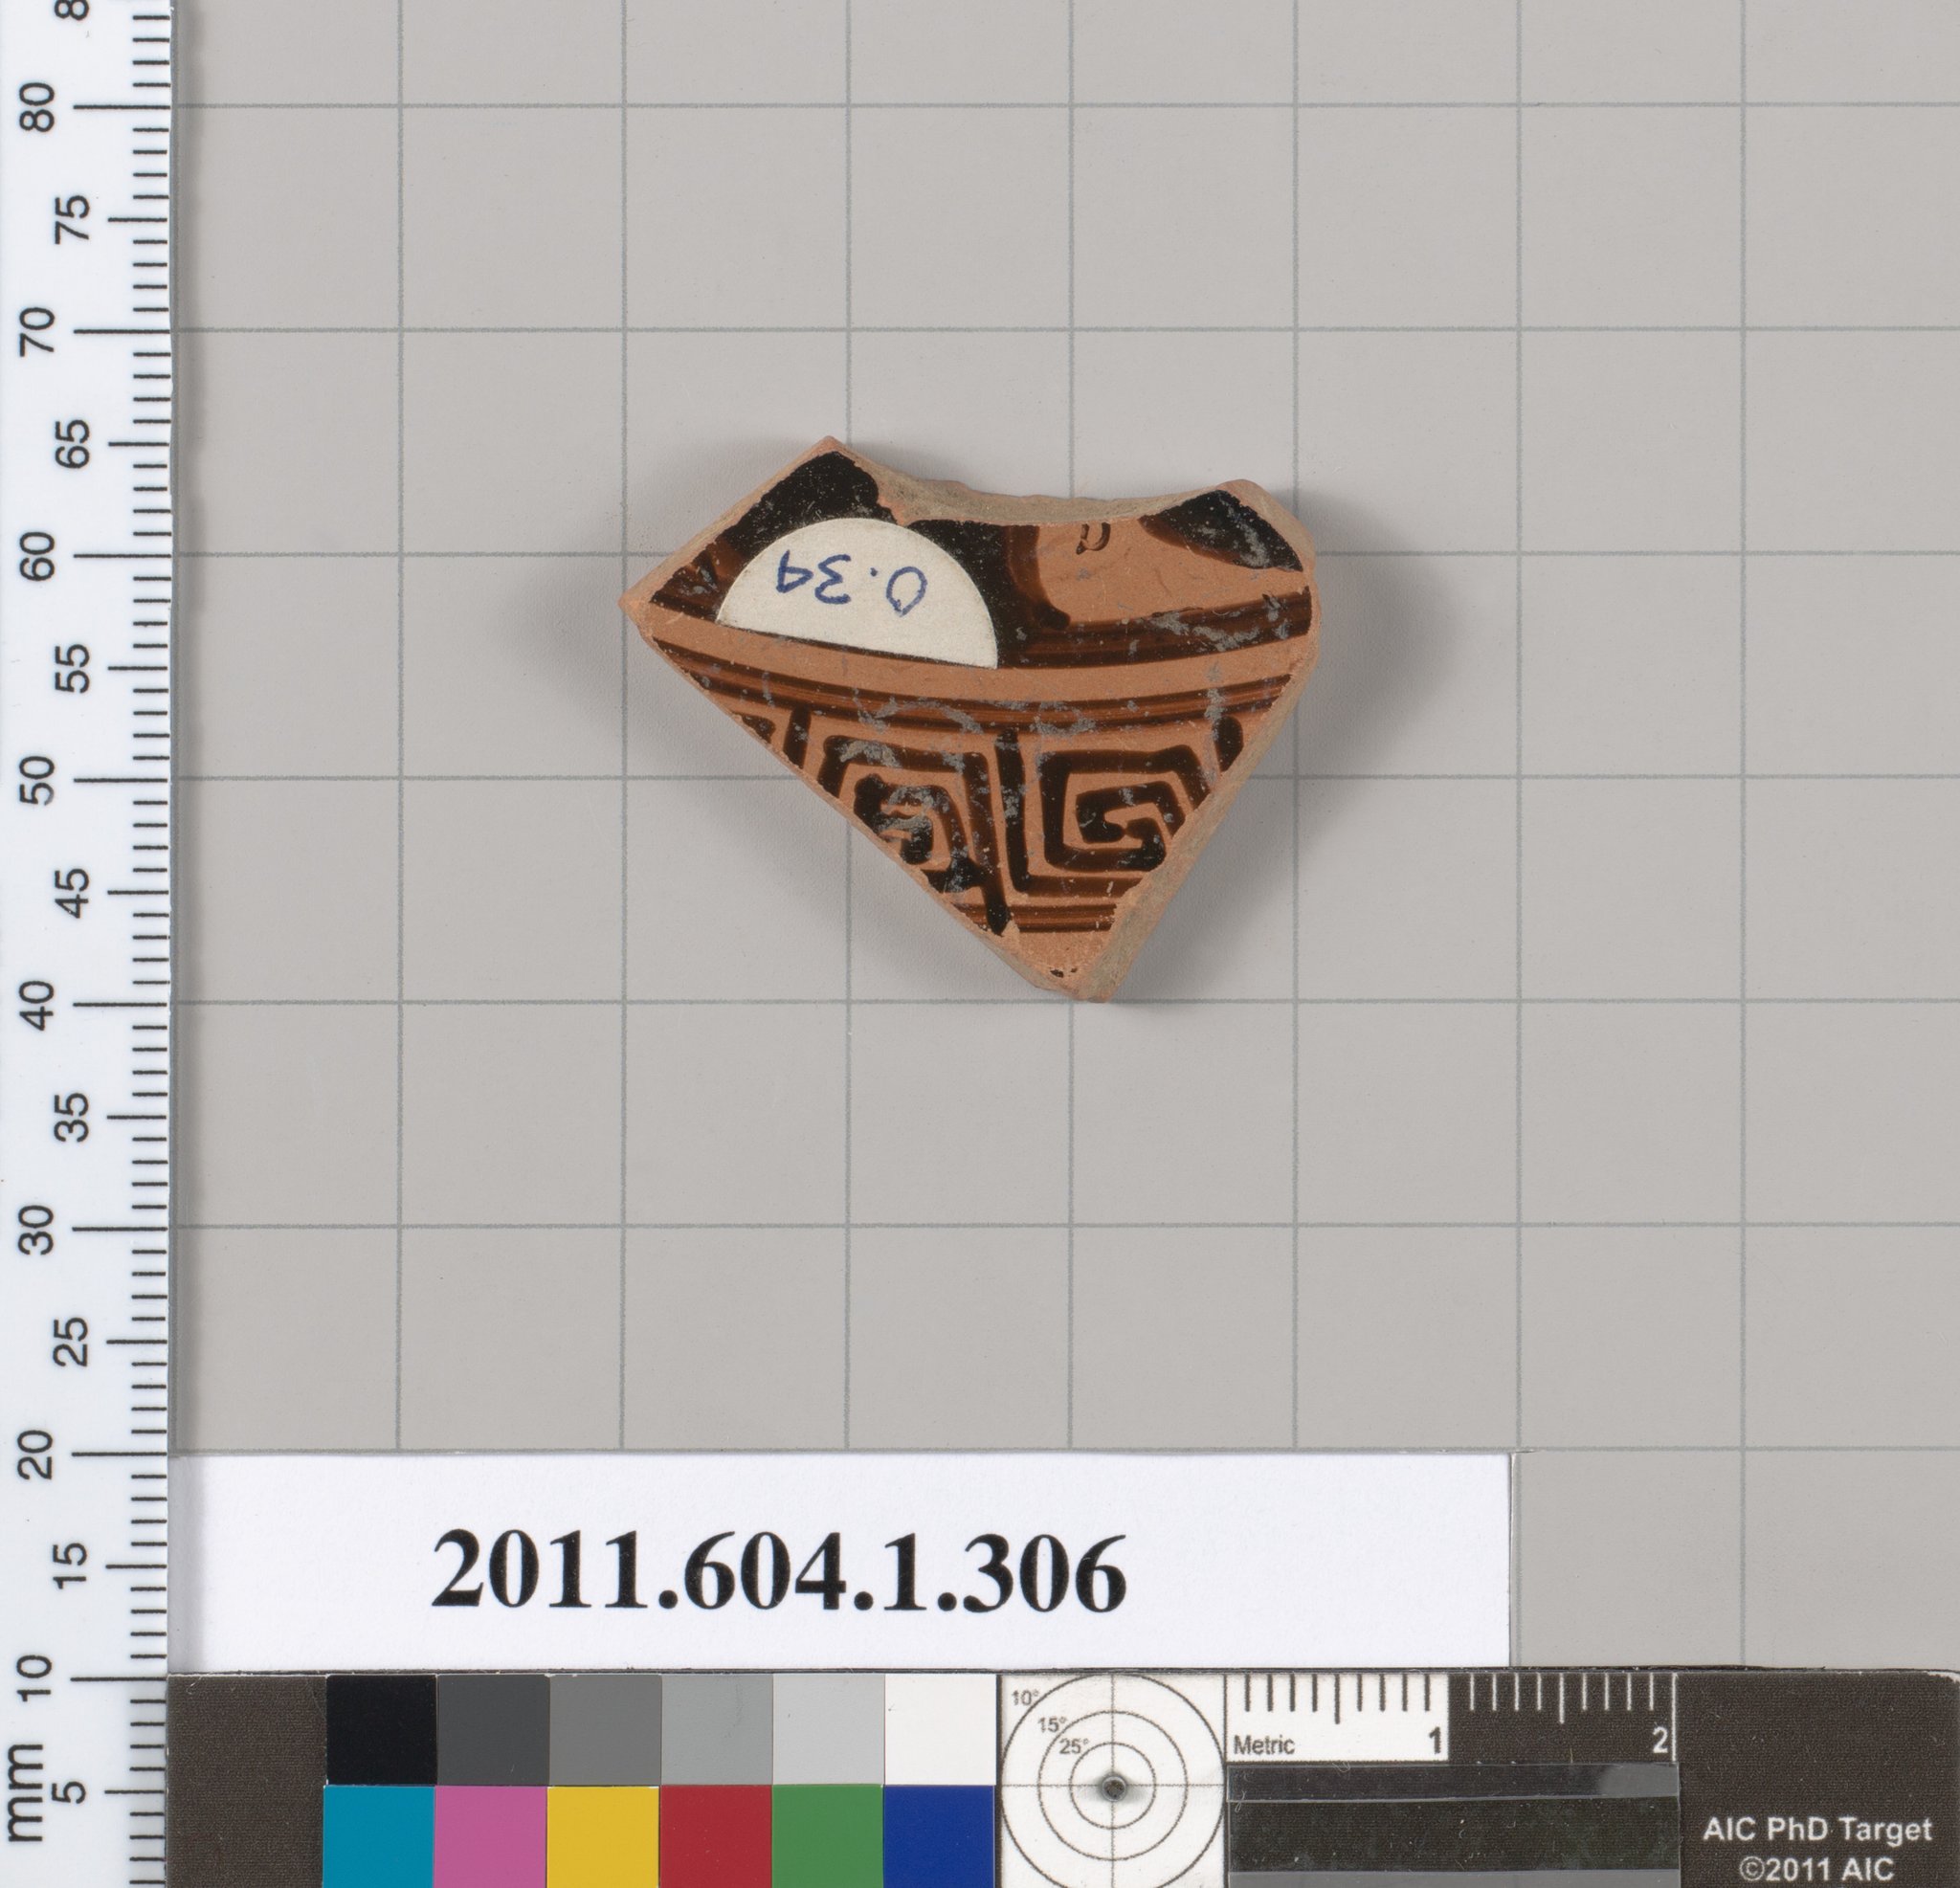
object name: kylix fragment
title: Terracotta fragment of a kylix (drinking cup)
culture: greek, attic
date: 475-451 BCE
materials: terracotta